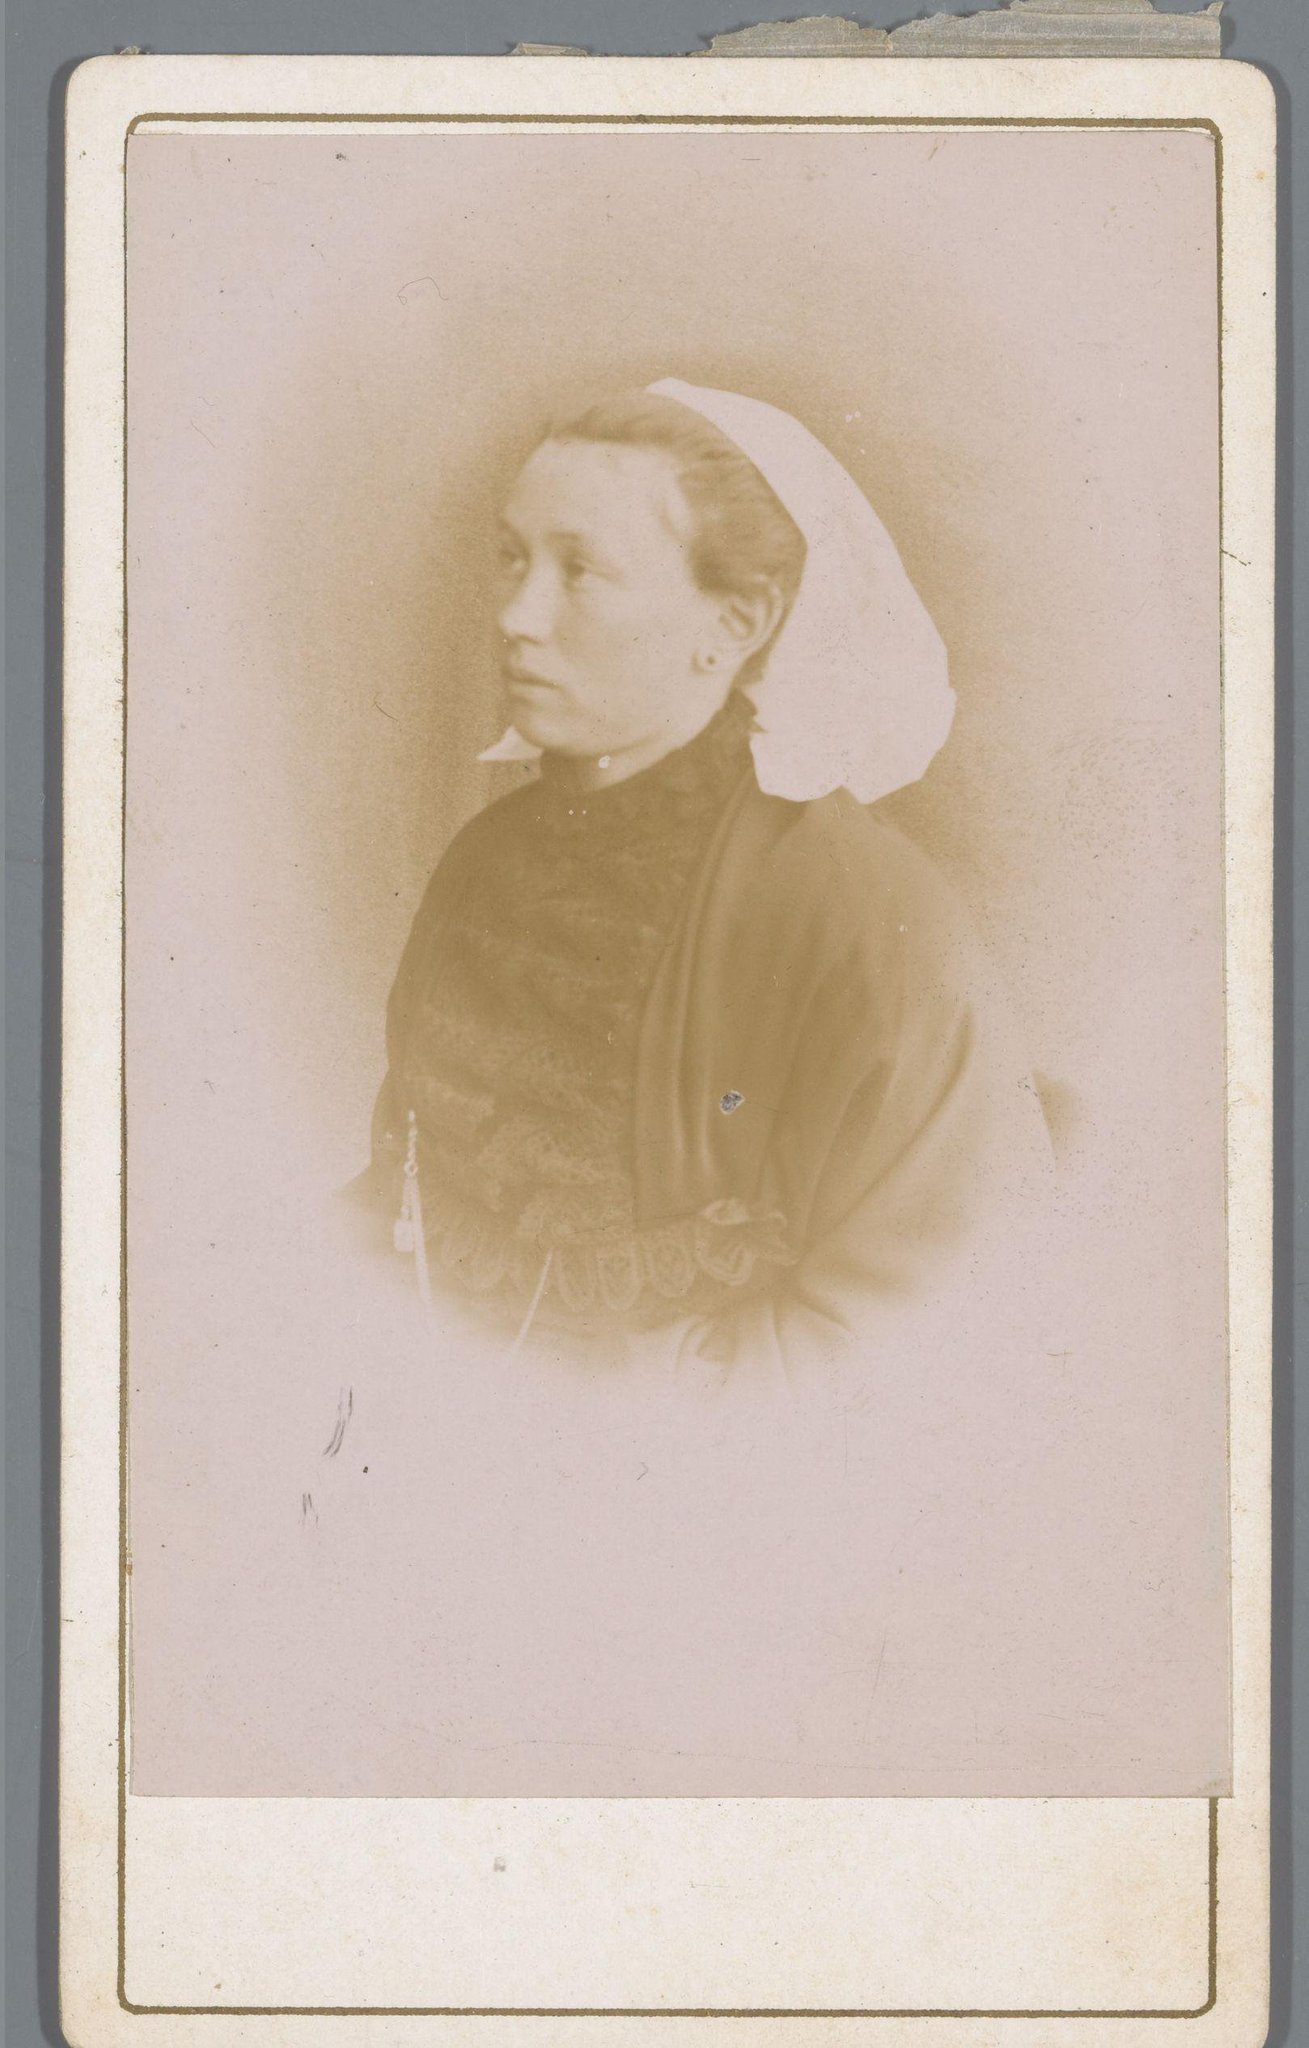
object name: carte de visite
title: Portret van een onbekende vrouw met hoofddeksel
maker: levasseur (fotograaf)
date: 1900-1914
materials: paper, cardboard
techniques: gelatin silver print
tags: adult woman, head-gear: cap, anonymous historical person portrayed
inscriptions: stamp: ‘PHOTOGRAPHIE POUR TOUS/ LAVASSEUR/ 3 MÉDAILLES’